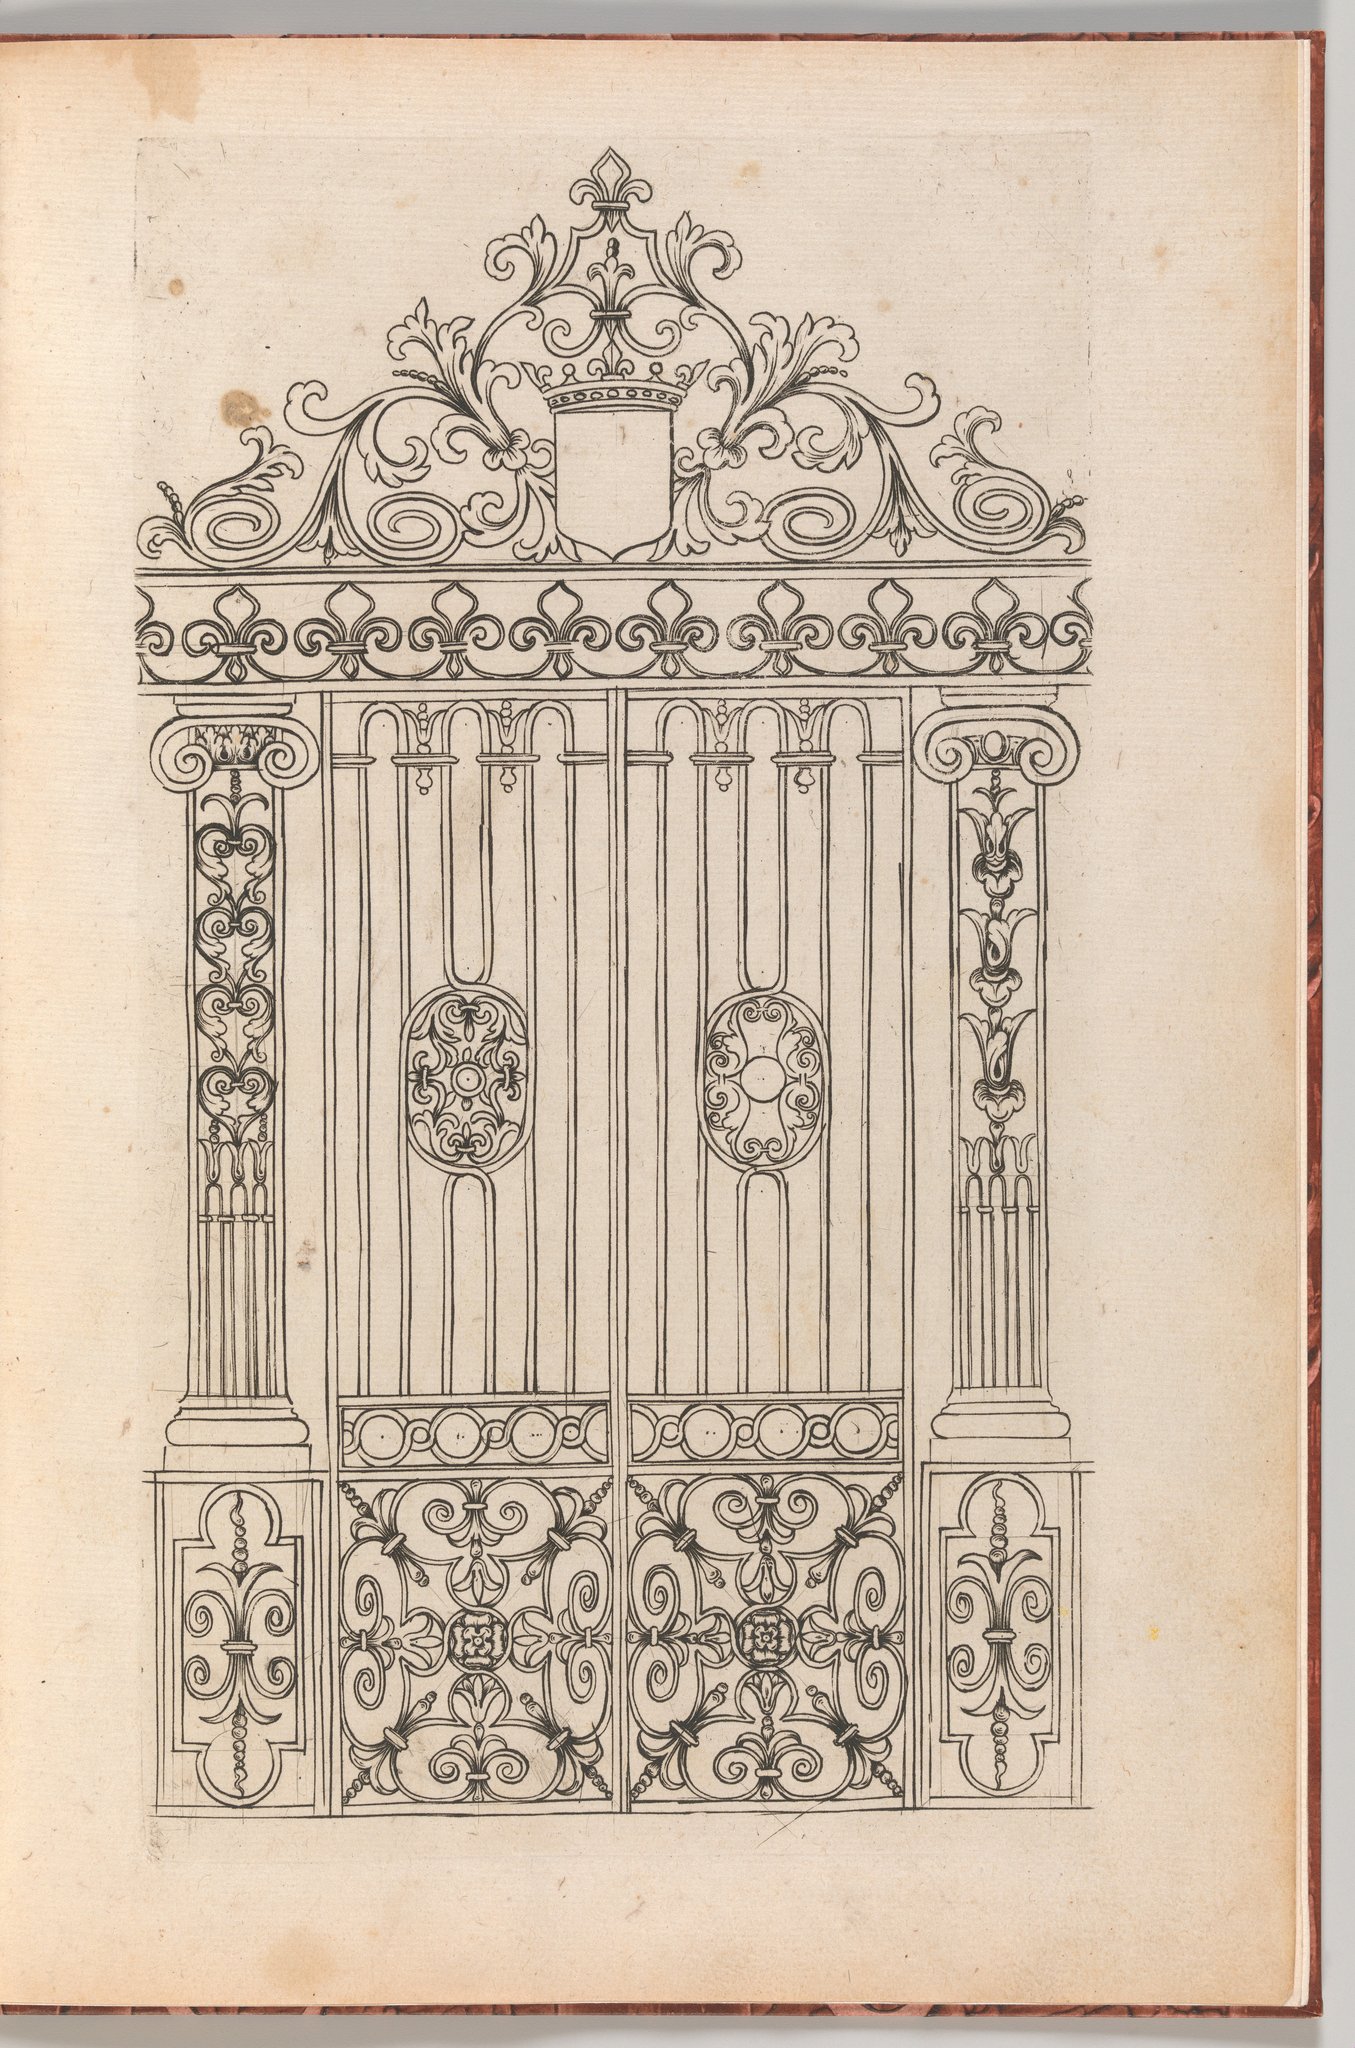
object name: album print ornament architecture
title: Diverses Pieces de Serruriers, page 17 (recto)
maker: jean berain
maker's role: artist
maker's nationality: french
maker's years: 1640-1711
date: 1663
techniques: engraving